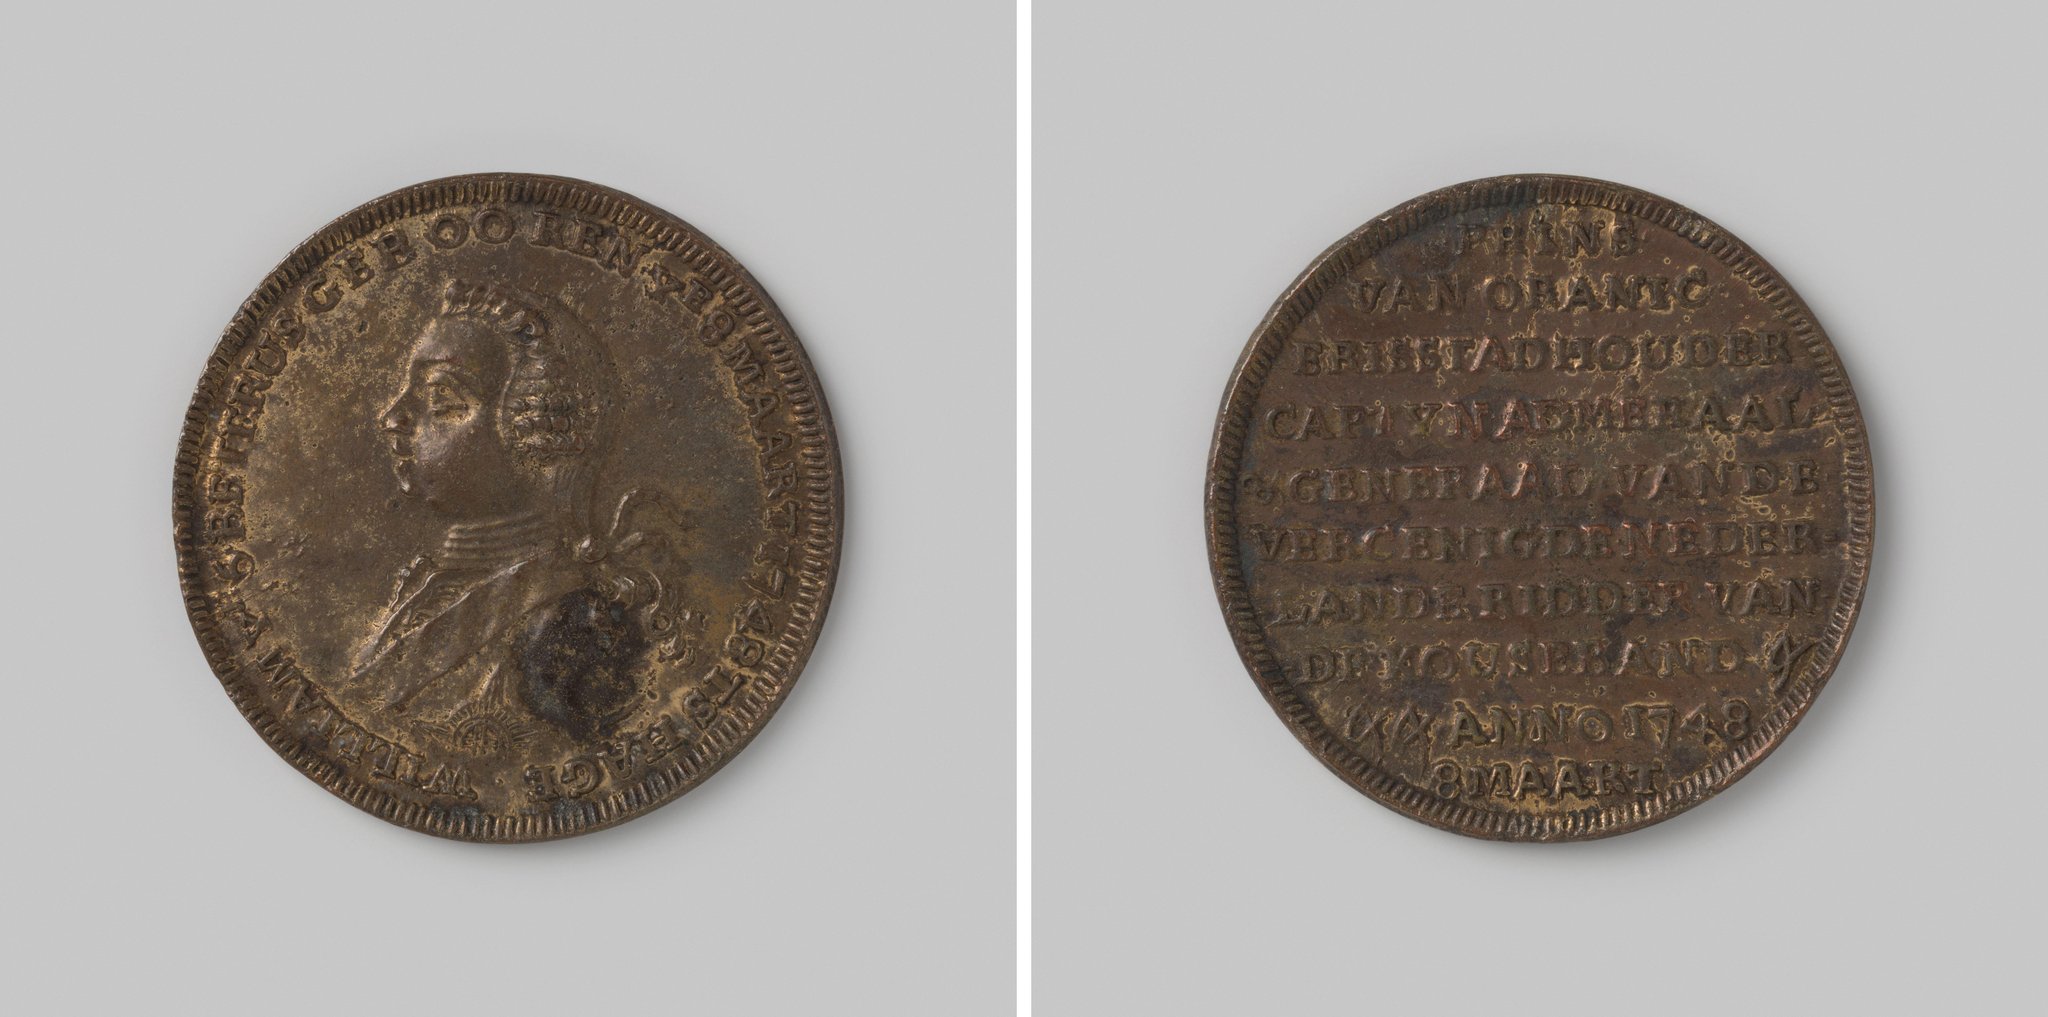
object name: history medal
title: Stadhouder Willem V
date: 1766-1795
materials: brass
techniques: casting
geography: england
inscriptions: circumscription: ‘WILLIAM YE 5 BETERUS GEBOOREN YE 8 MAART 1748 TS HAGE’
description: Messing penning, op de voorzijde het borstbeeld van Willem V naar links, met omschrift, op de keerzijde tien regels tekst.